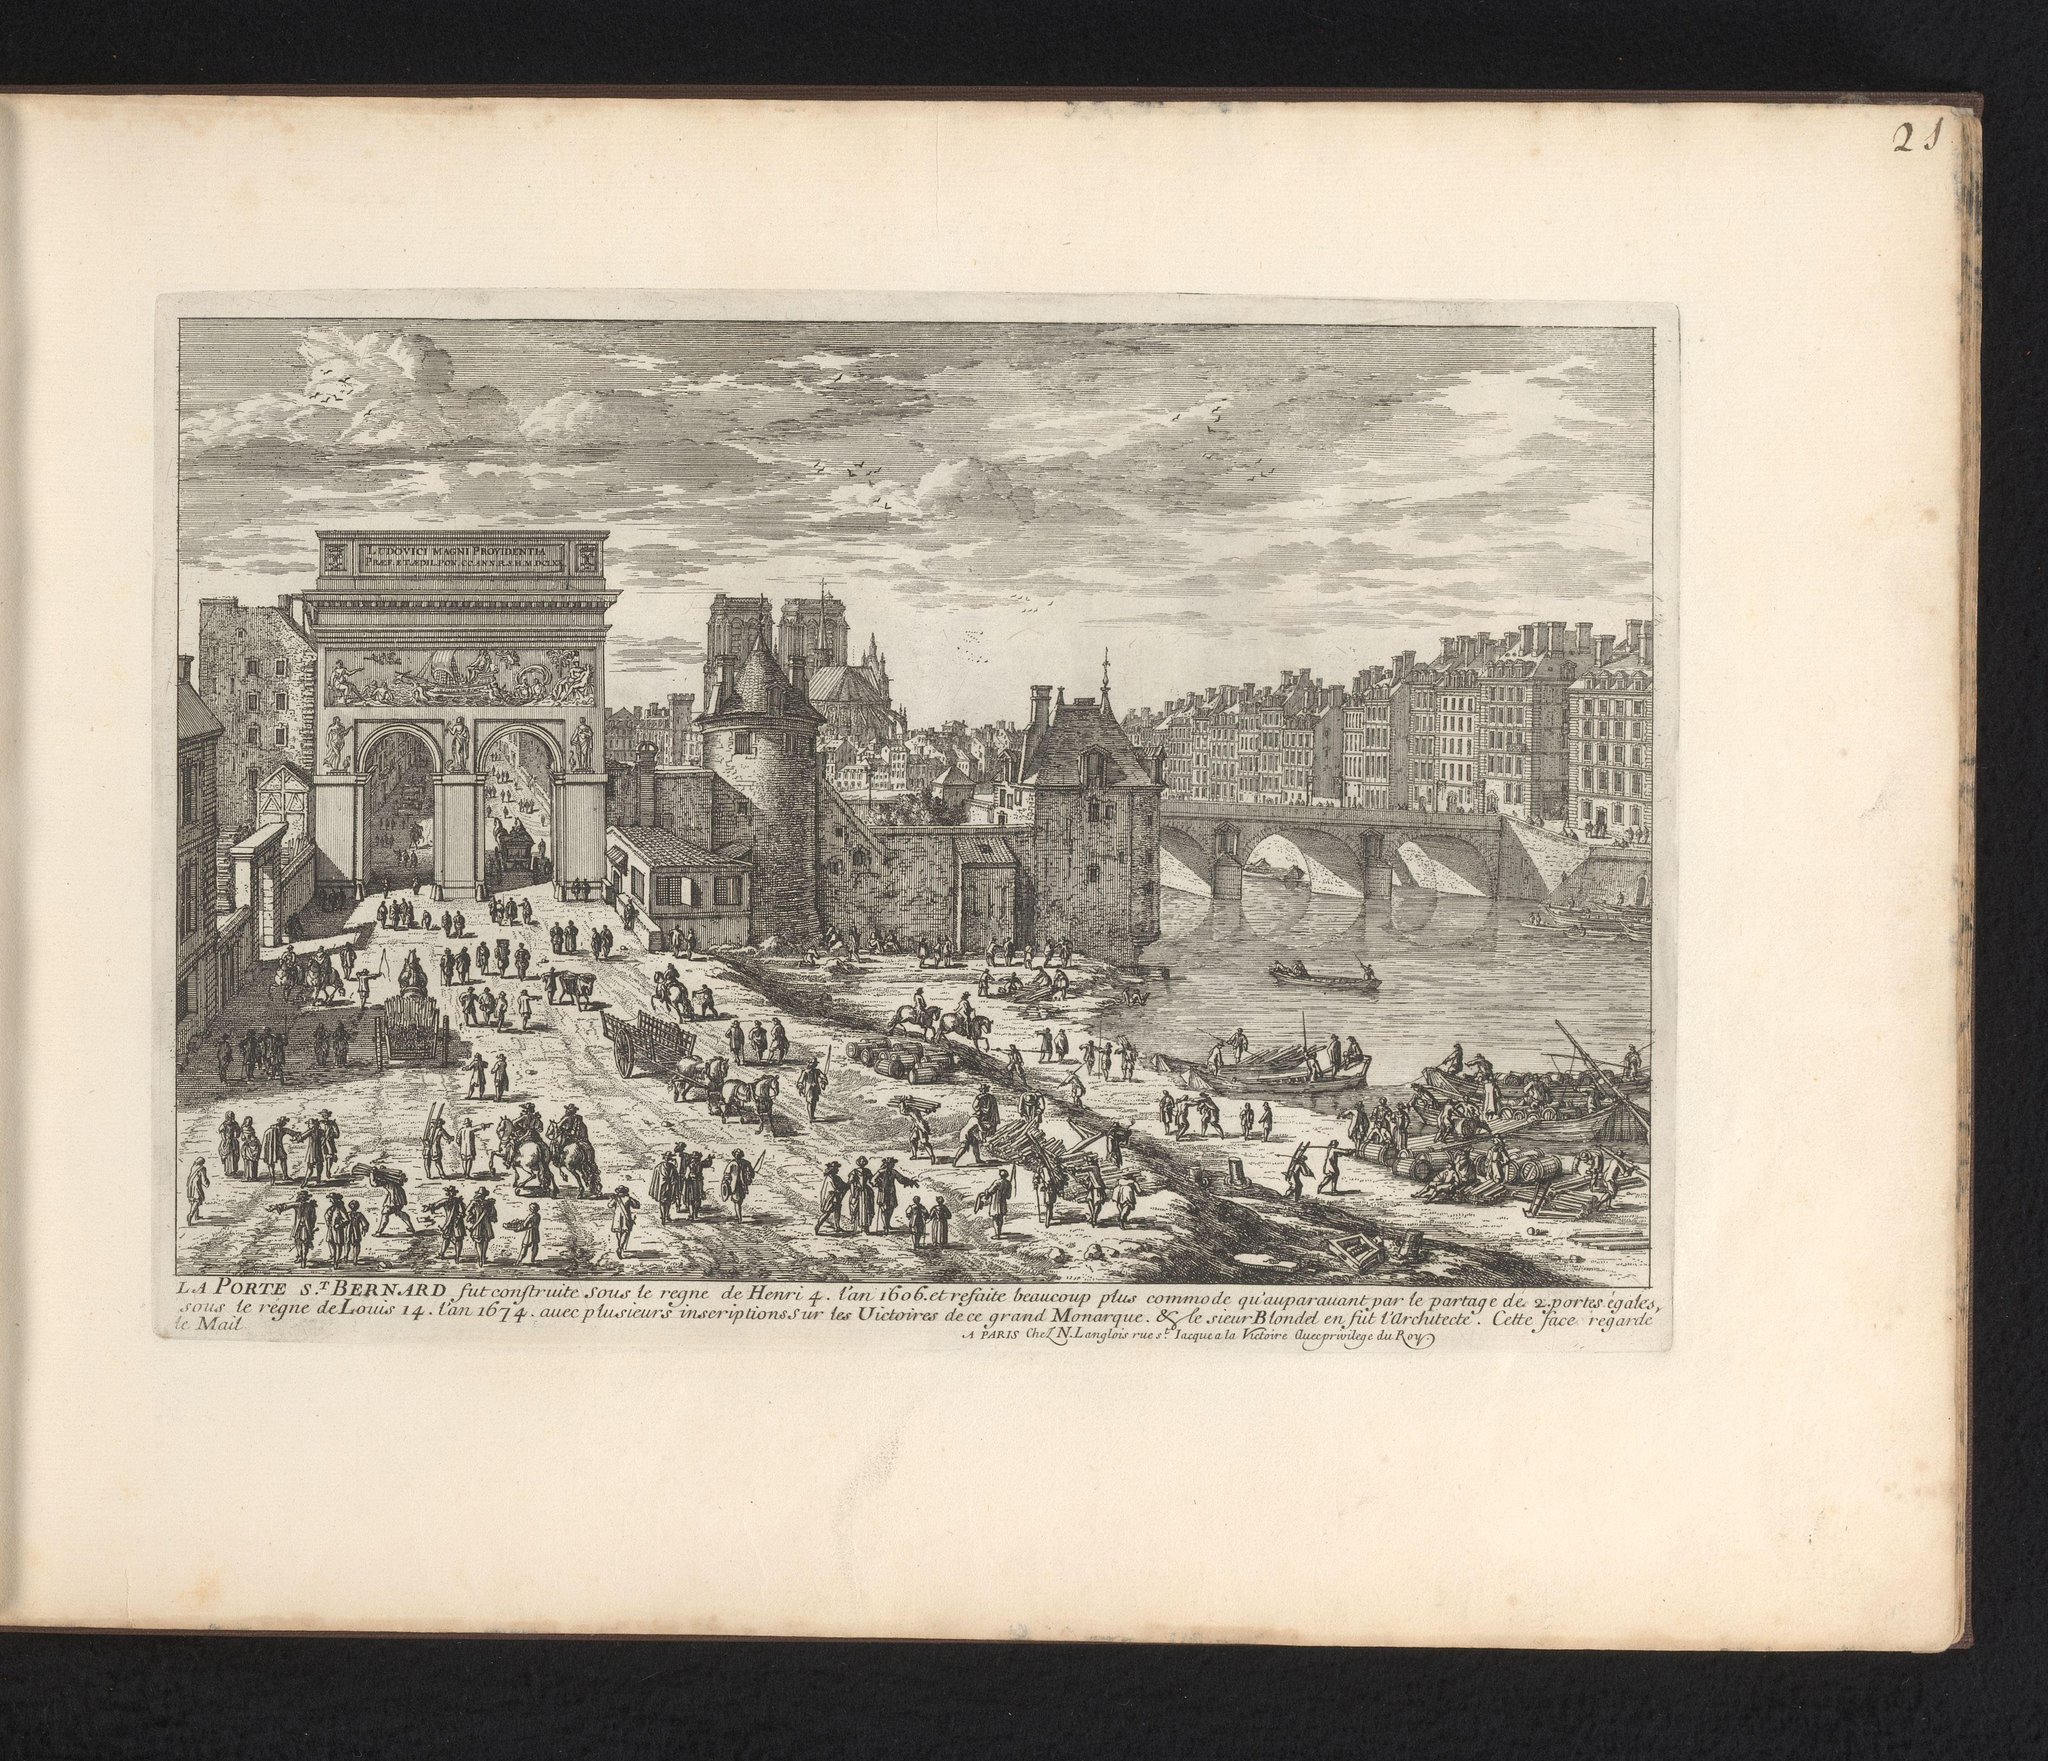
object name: album leaf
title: Stadsgezichten en landschappen in Frankrijk en Italië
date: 1674-1695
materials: paper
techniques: etching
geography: france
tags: bridge in city across river, canal, etc., city-gate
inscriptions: collector's mark: Lugt 2228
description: Prenten met het signatuur 'Perelle' kunnen zowel door vader Gabriel als door zonen Nicolas en Adam gemaakt zijn. De uitgevers vader en zoon Nicolas Langlois worden allebei vermeld als N. Langlois op hetzelfde adres.